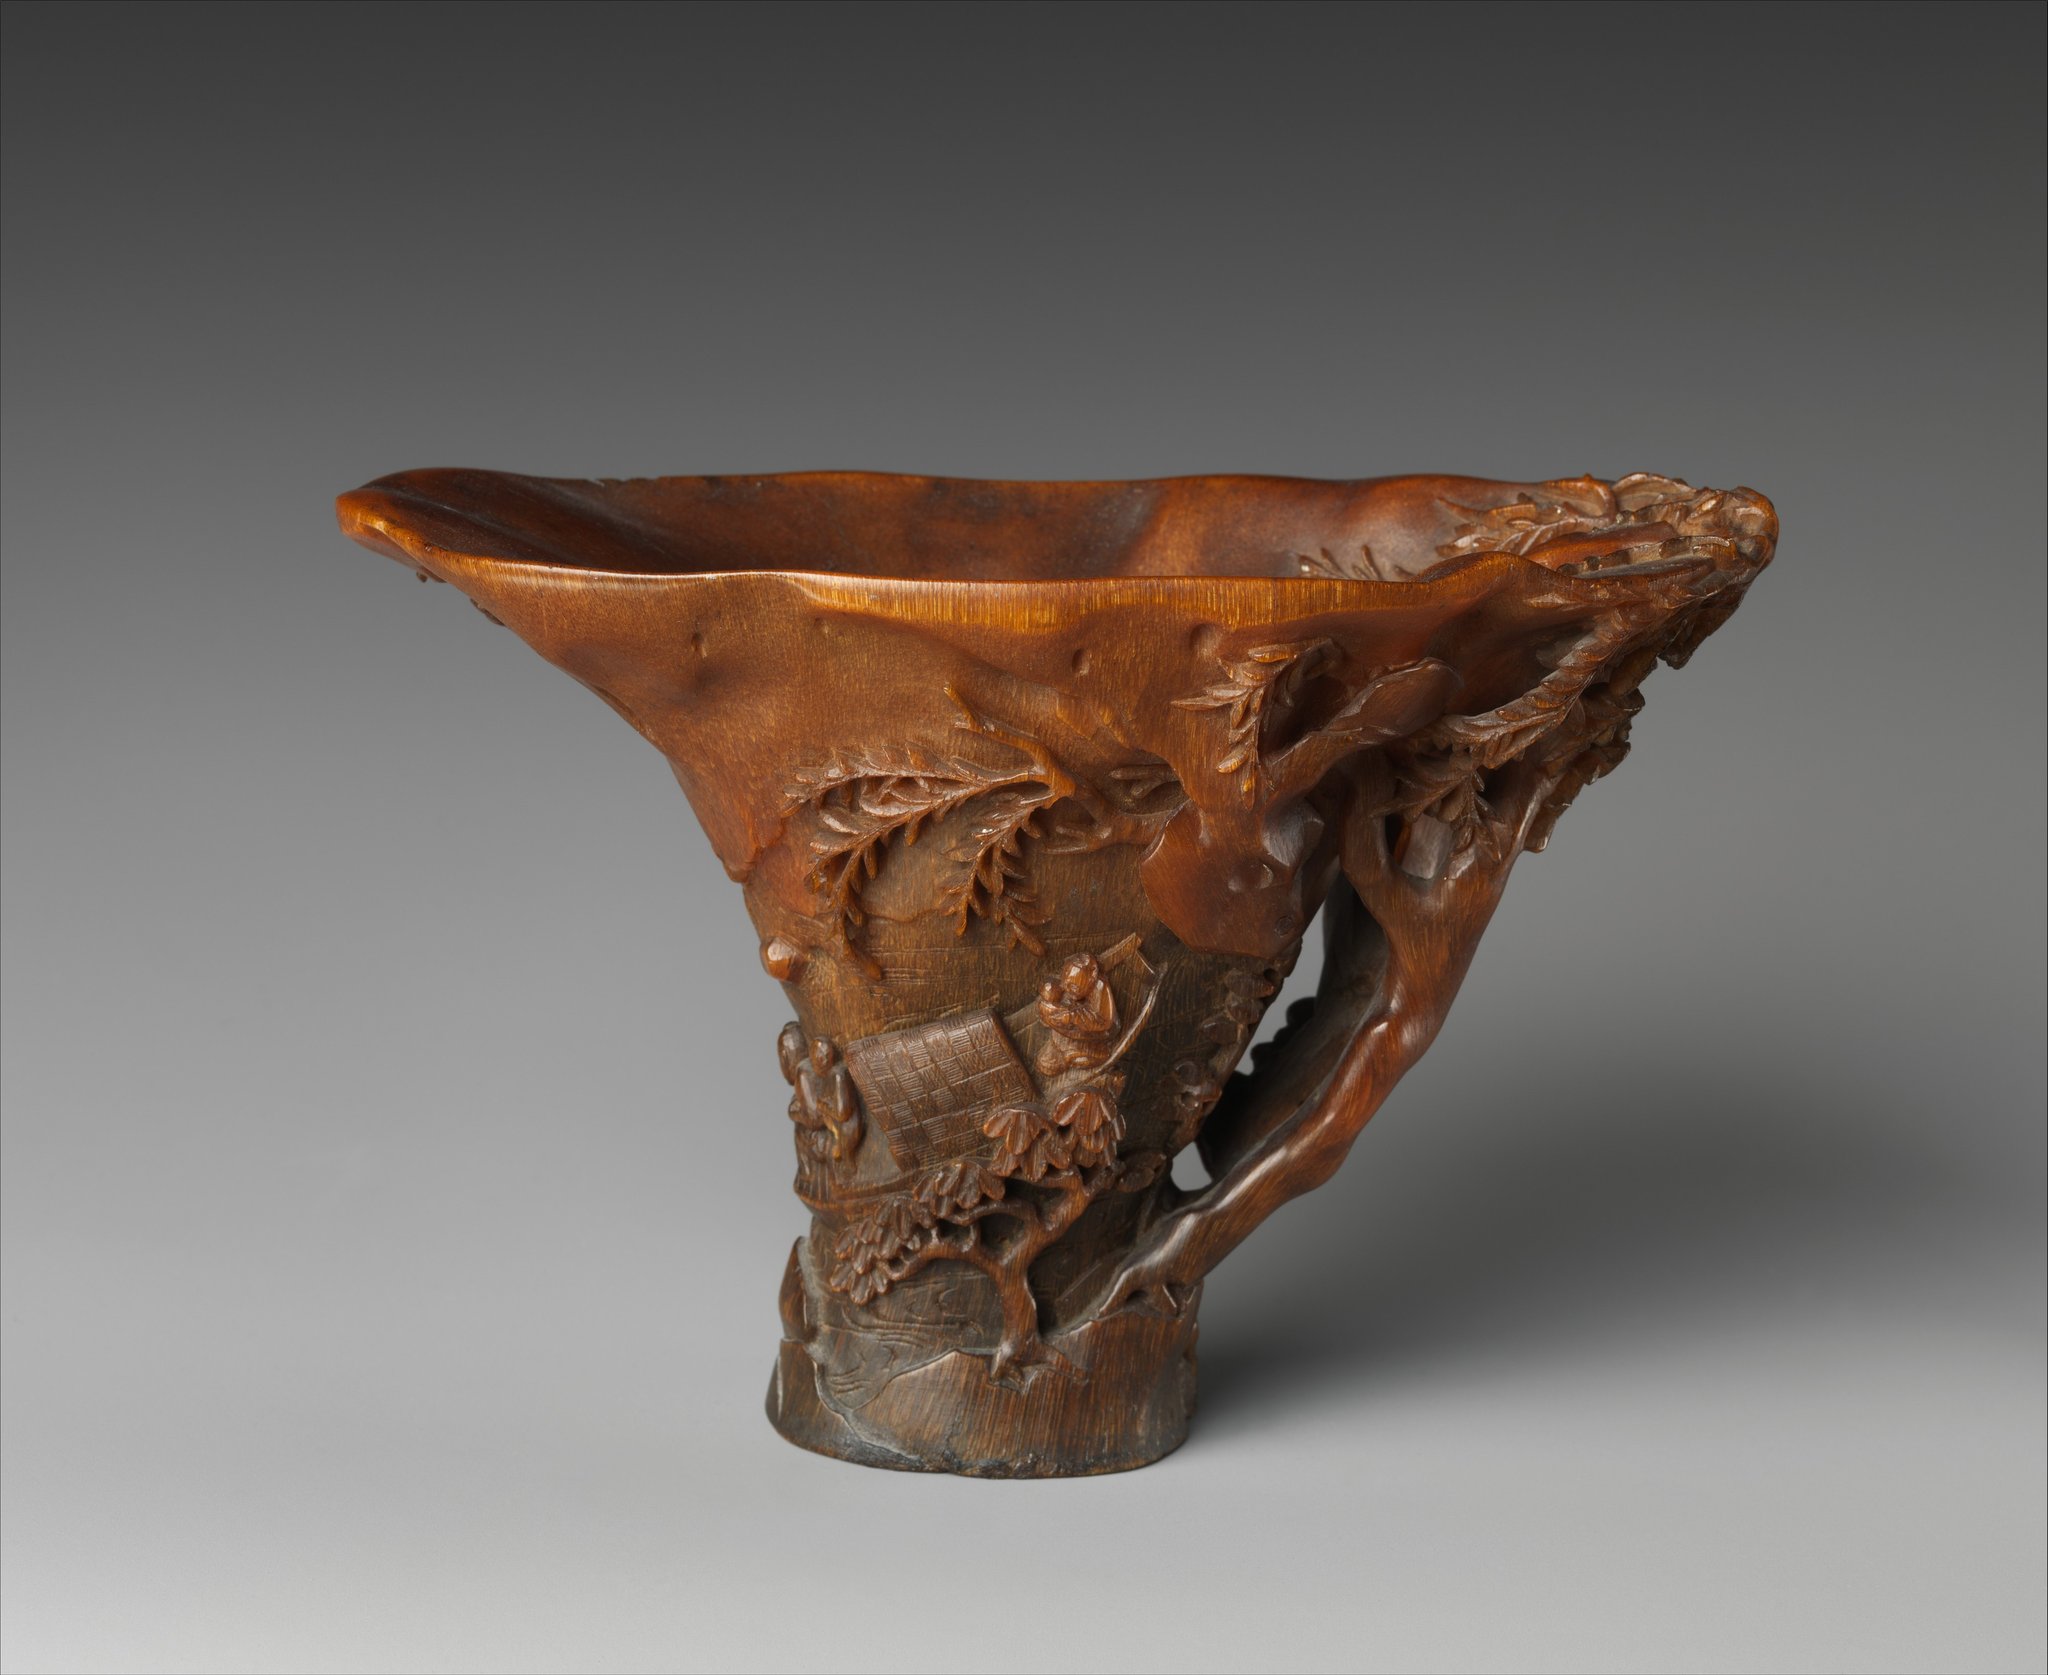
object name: cup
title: Libation cup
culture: chinese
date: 1701-1800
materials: horn